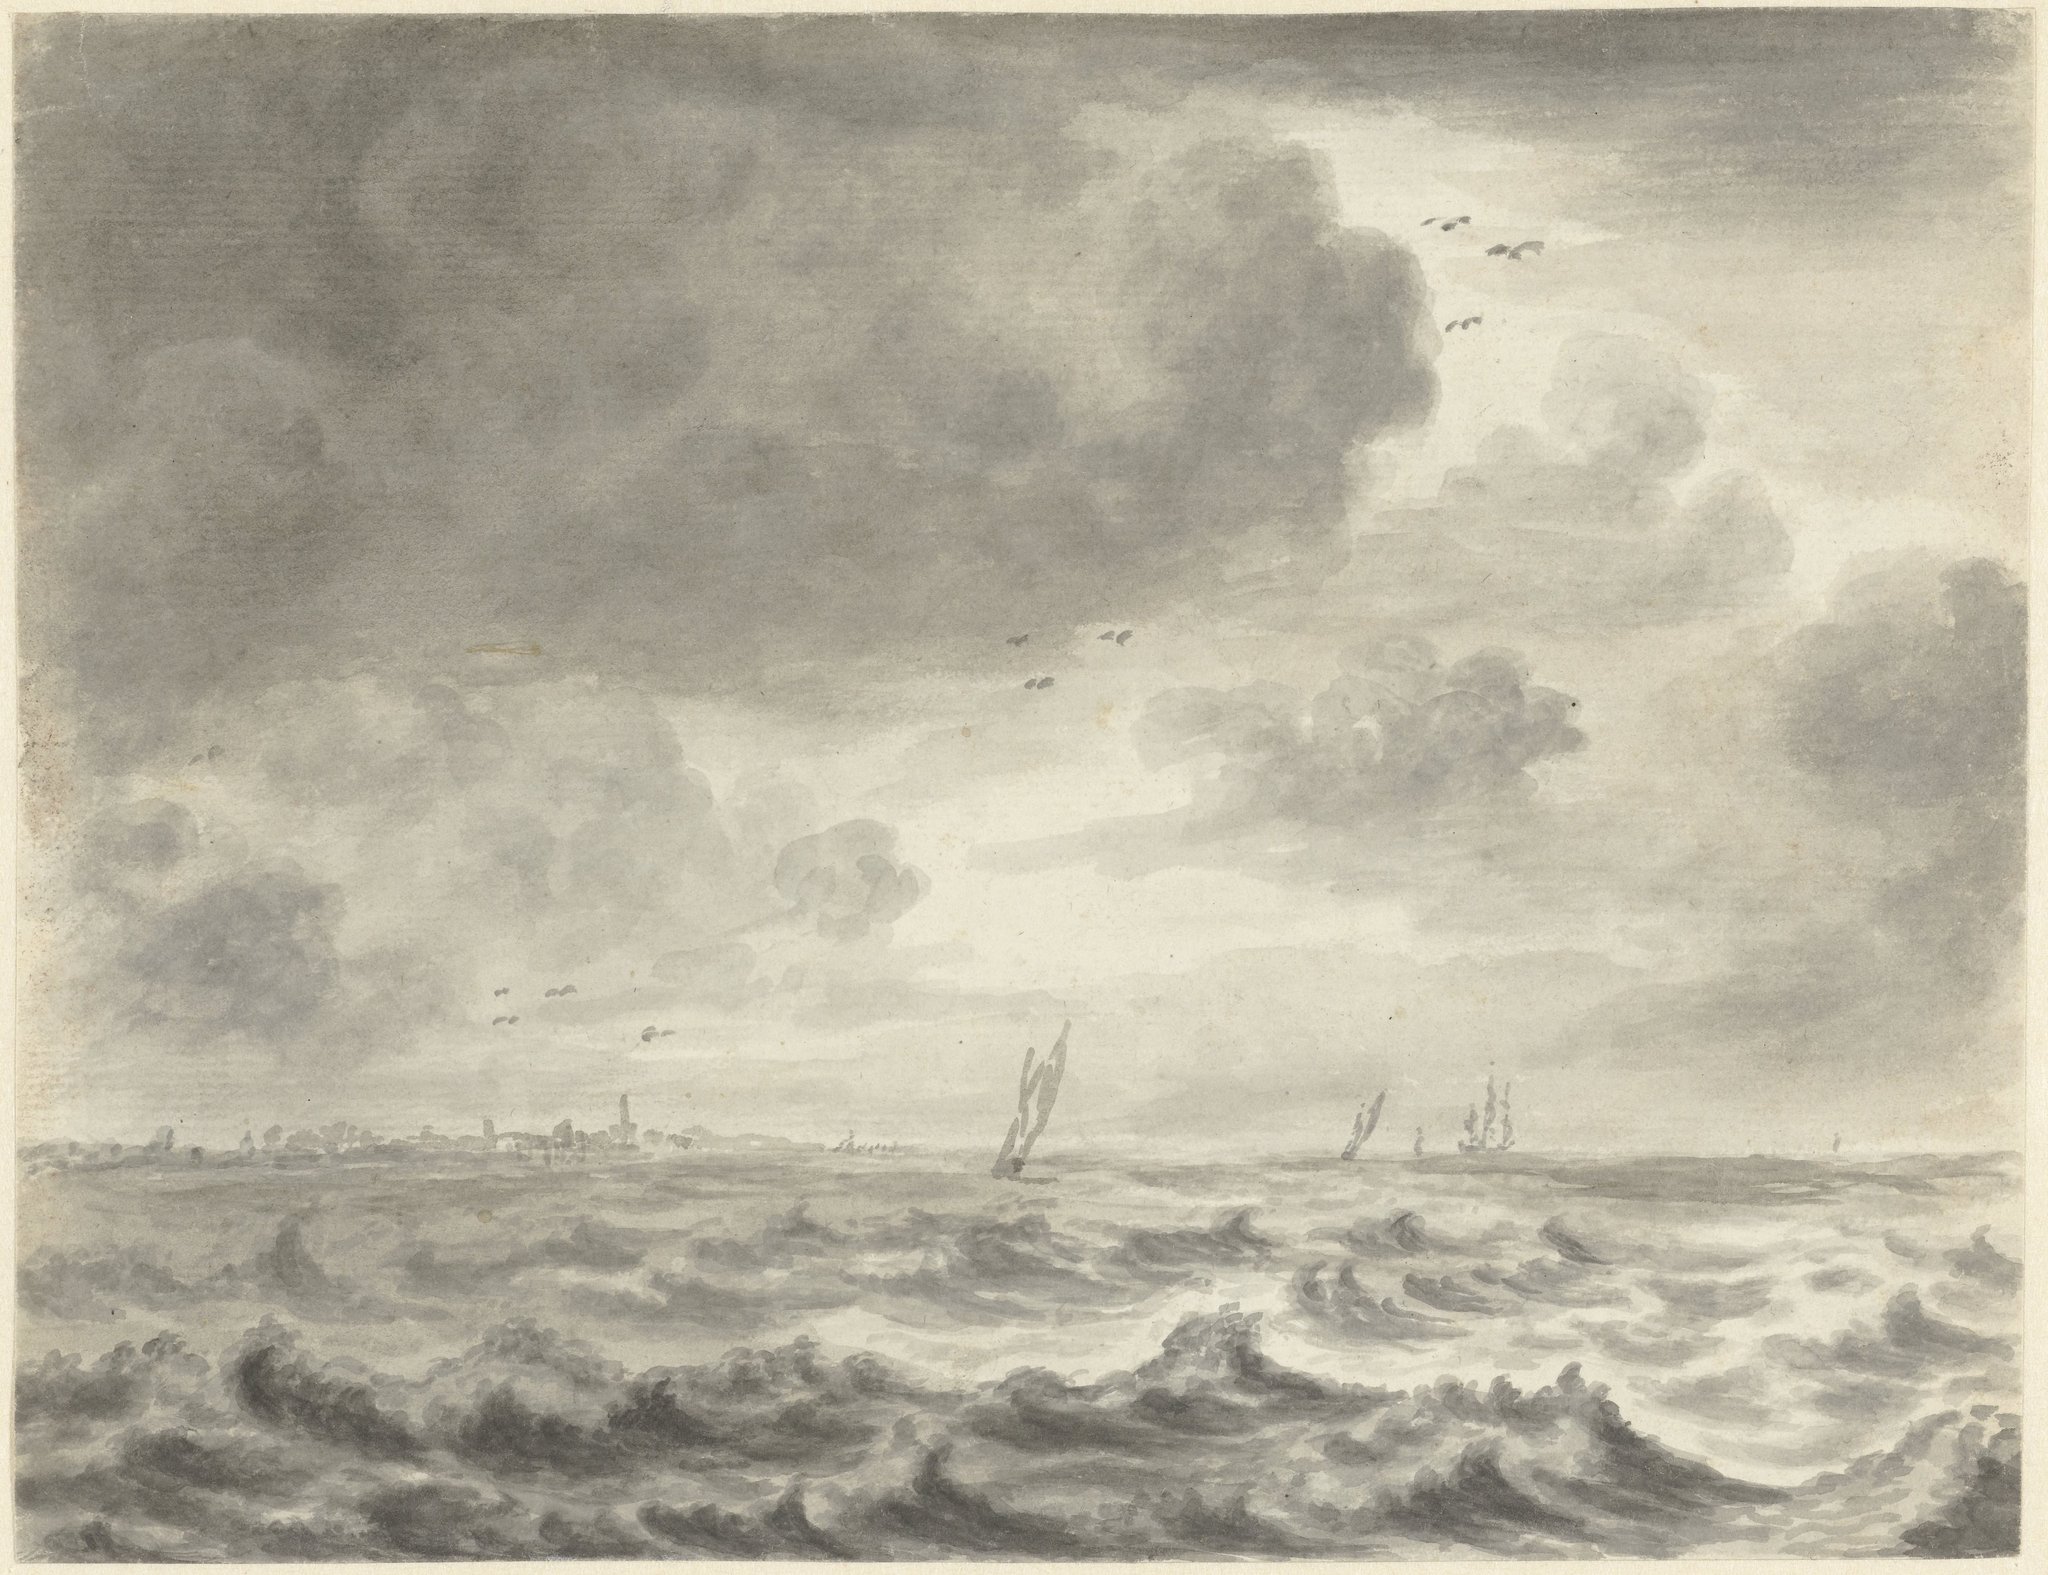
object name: drawing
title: Zeegezicht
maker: pieter idserts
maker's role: draughtsman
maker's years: 1698-1781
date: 1708-1781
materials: paper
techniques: brush